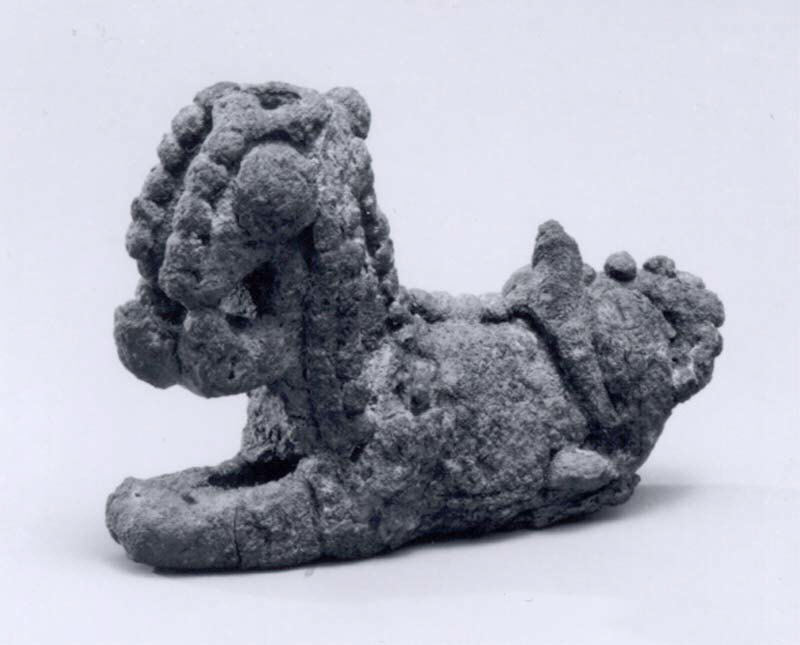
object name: pin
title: Lion pin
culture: iranian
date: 900-801 BCE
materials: bronze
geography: iran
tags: lions